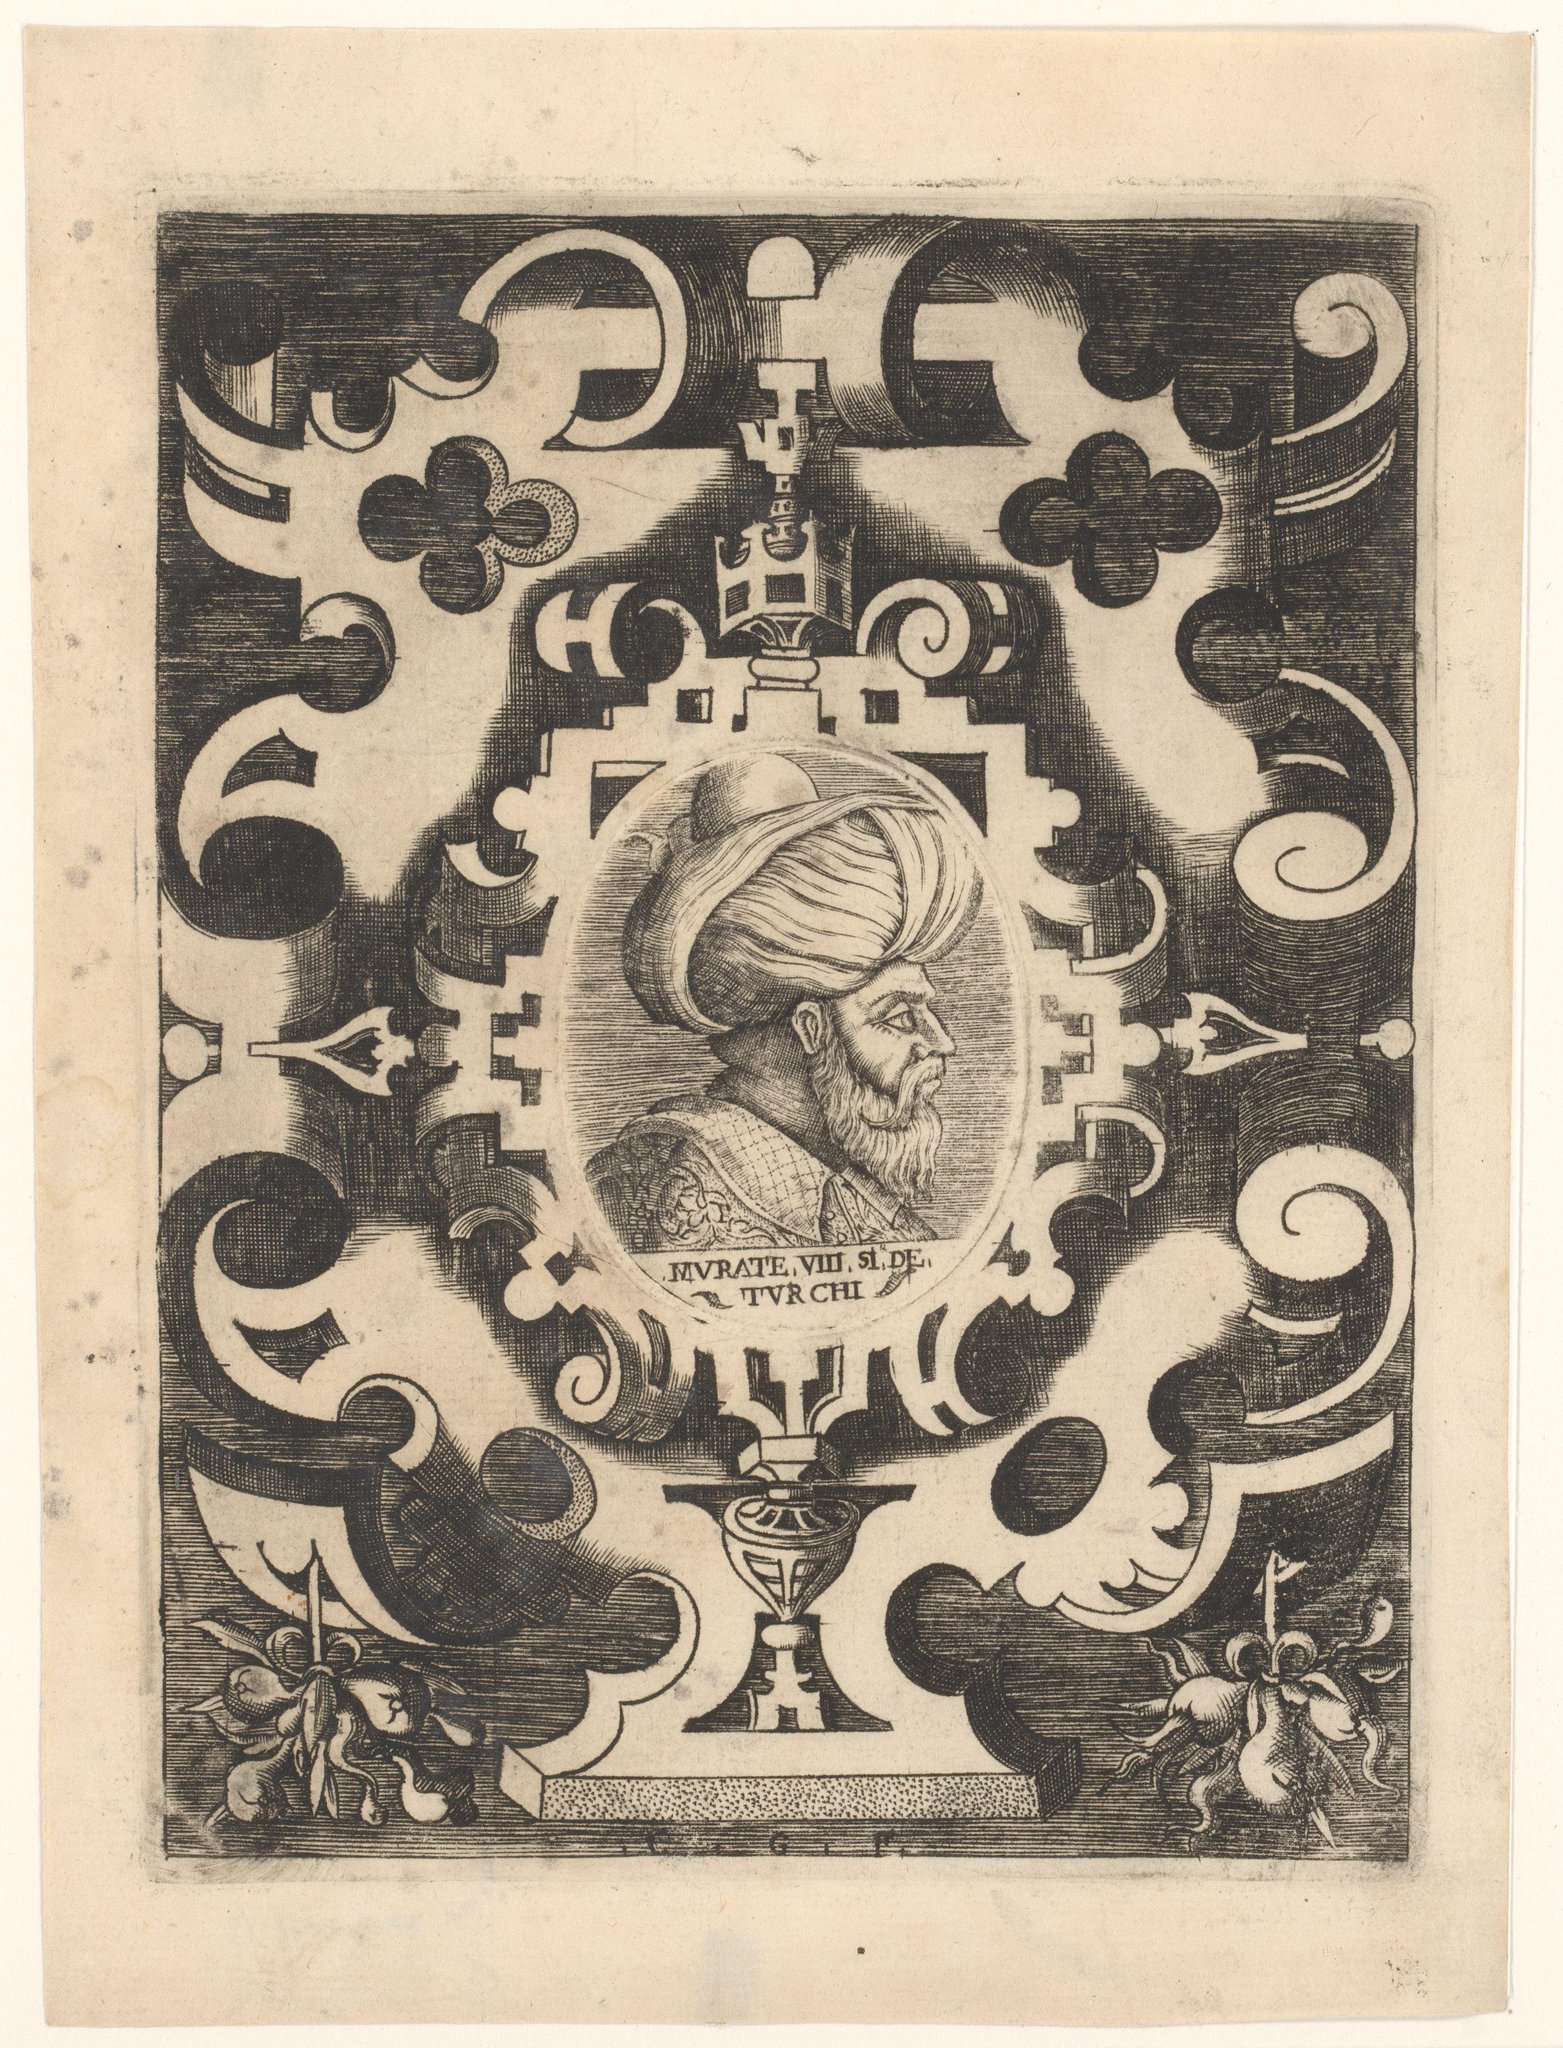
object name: print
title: Portret van de Turkse Sultan Murat III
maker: camillo graffico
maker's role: print maker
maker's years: 1565-1615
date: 1591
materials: ink, paper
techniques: engraving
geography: venice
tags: historical persons, ranks ~ rulers, sovereigns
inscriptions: collector's mark: Lugt 2760, collector's mark: Lugt 2228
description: De gravures van Camillo Graffico met portretten van Turkse sultans zijn afkomstig uit een serie met een titelprent met de tekst: Natturalli e verri rettrati d tuti li Signiori de Turchi, uitgegeven in Venetië in 1591. De omvang van de reeks is niet bekend. De ornamentele omlijsting is gedrukt van een aparte plaat. Dezelfde plaat werd eerder gebruikt door Graffico voor een serie met portretten van de keizers van het Heilig Roomse Rijk, uitgegeven in 1584 (zie Metropolitan Museum of Art, New York).